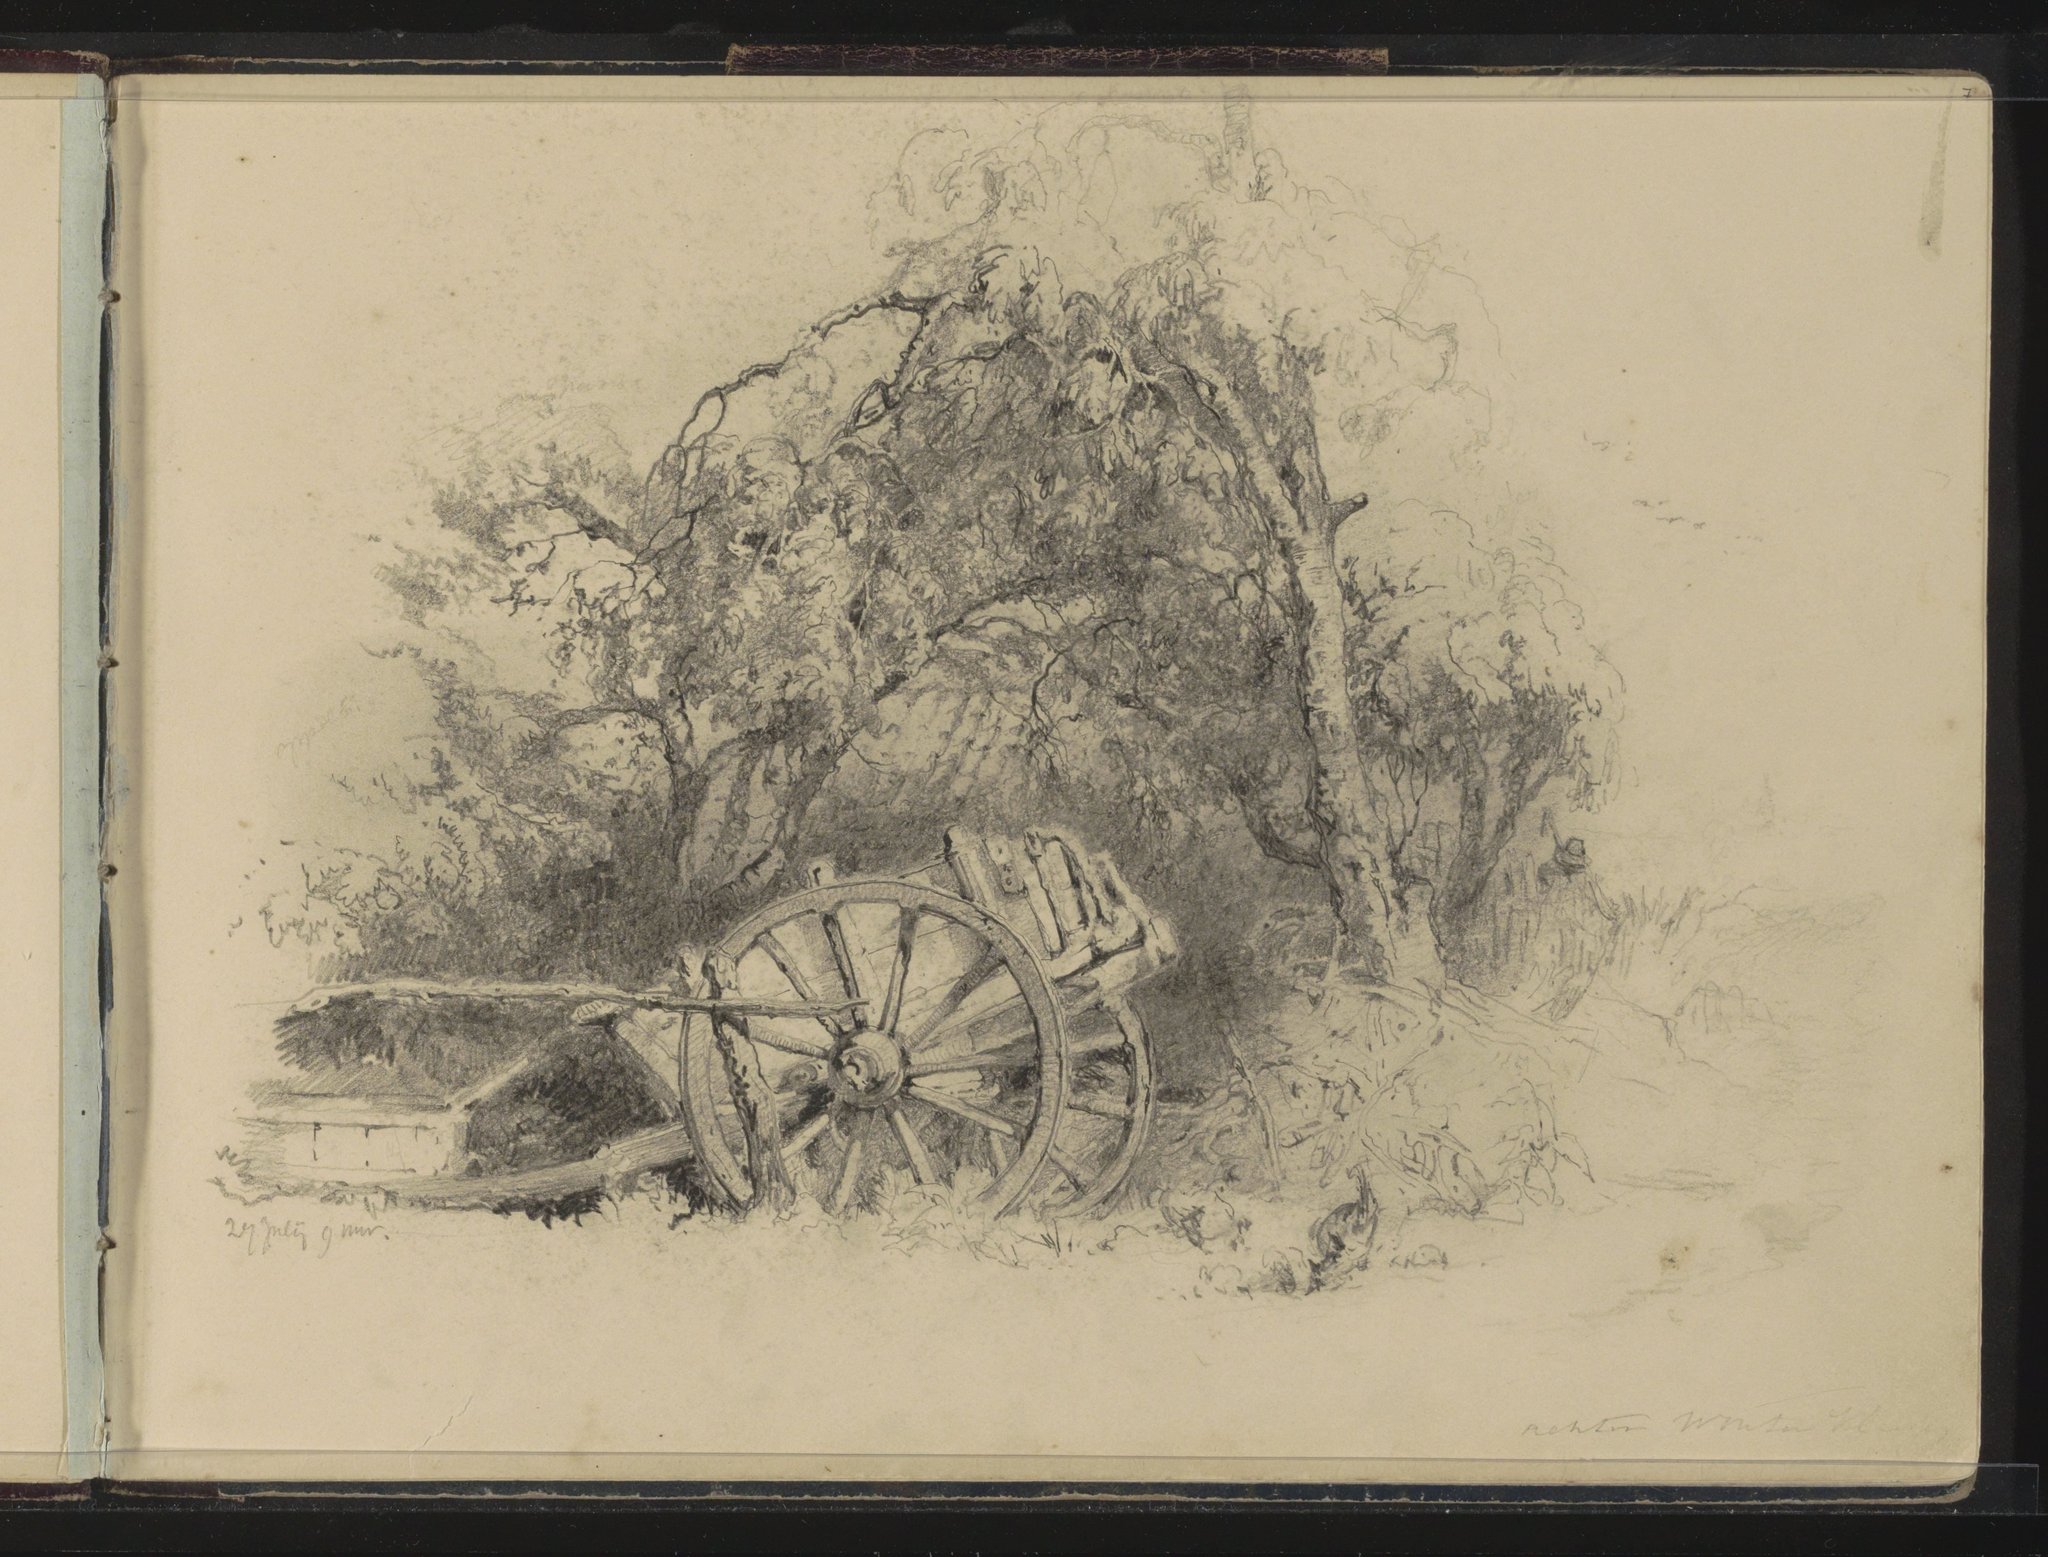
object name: sketchbook leaf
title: Boerenkar met een overhangende boom achter de Wouter Klaassenlaan in Oosterbeek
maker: maria vos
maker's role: draughtsman, painter, print maker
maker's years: 1824-1906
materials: paper, pencil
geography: oosterbeek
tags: (farm) wagon, freight wagon, cart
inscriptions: date and inscription: ‘27 Julij 9 uur/ achter wouter klaassen’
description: Blad 7 recto uit een schetsboek met 44 bladen.